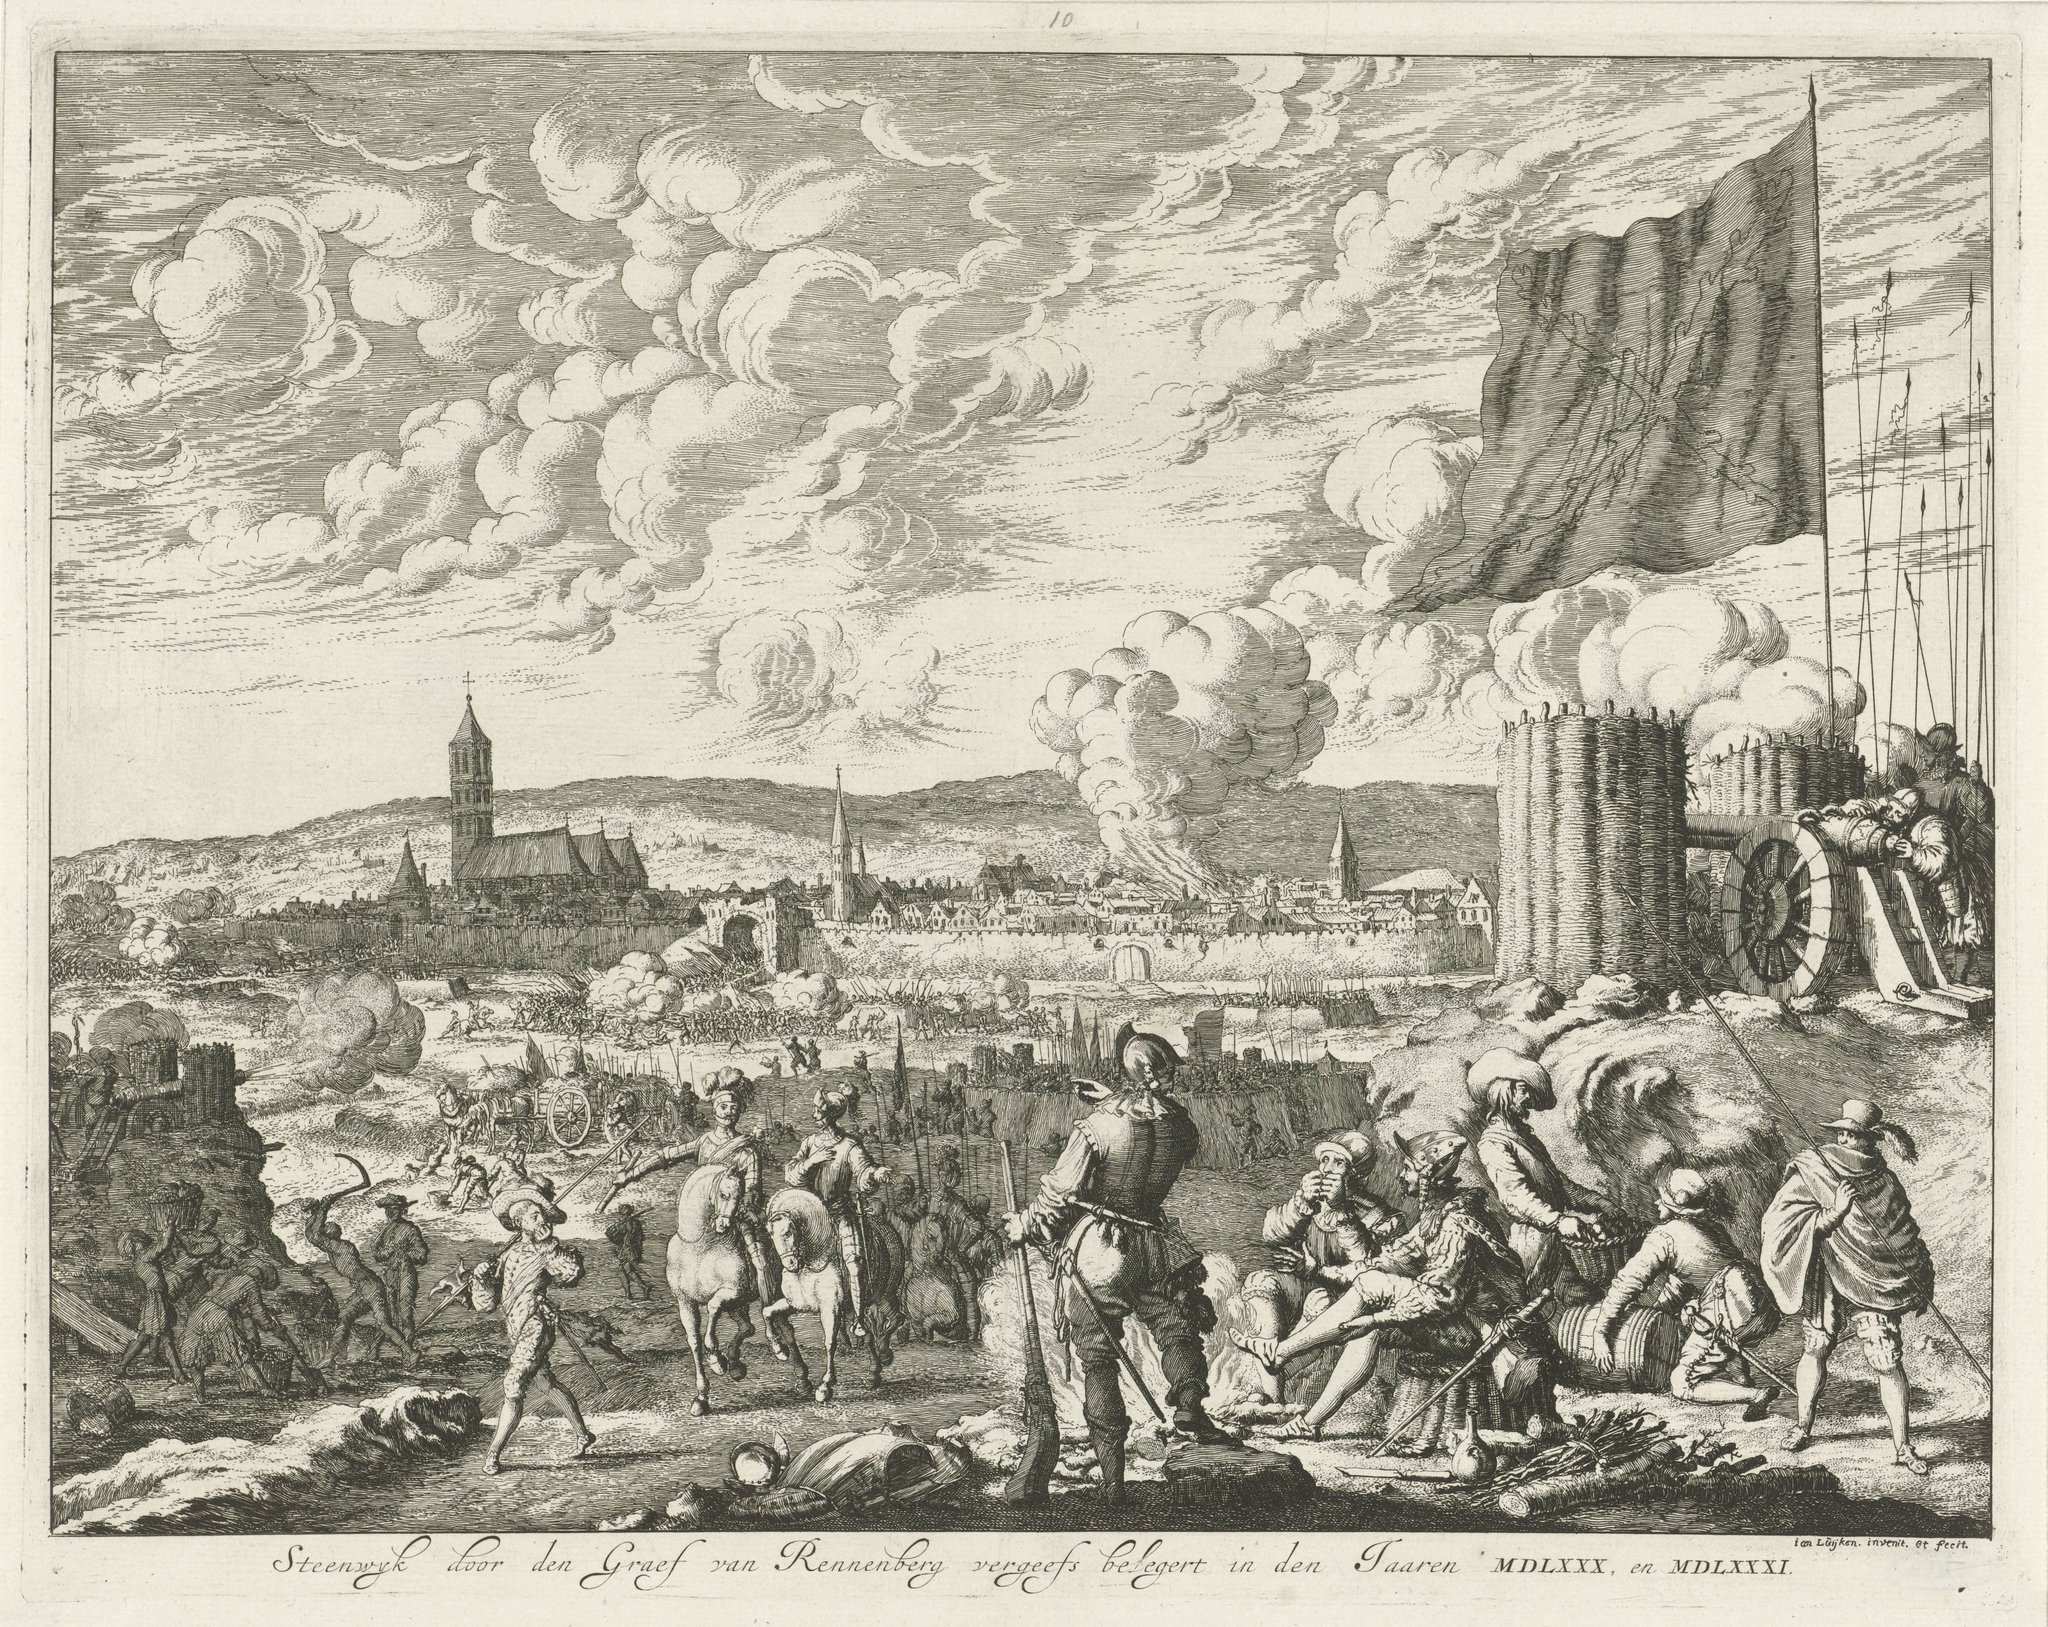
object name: print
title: Steenwyk door den Graef van Rennenberg vergeefs belegert in den Jaaren MDLXXX en MDLXXXI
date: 1679-1684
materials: paper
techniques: etching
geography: amsterdam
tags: groningen (province), capture of city (after the siege)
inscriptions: collector's mark: Lugt 2228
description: Illustratie gebruikt in: Bor Christiaansz, Pieter. Oorsprongk, begin, en vervolgh der Nederlandsche oorlogen, 4 delen, dl. II, p. 239. Amsterdam: weduwe Joannes van Someren, Abraham Wolfgang, Hendrick en Dirk Boom, 1679-1684.